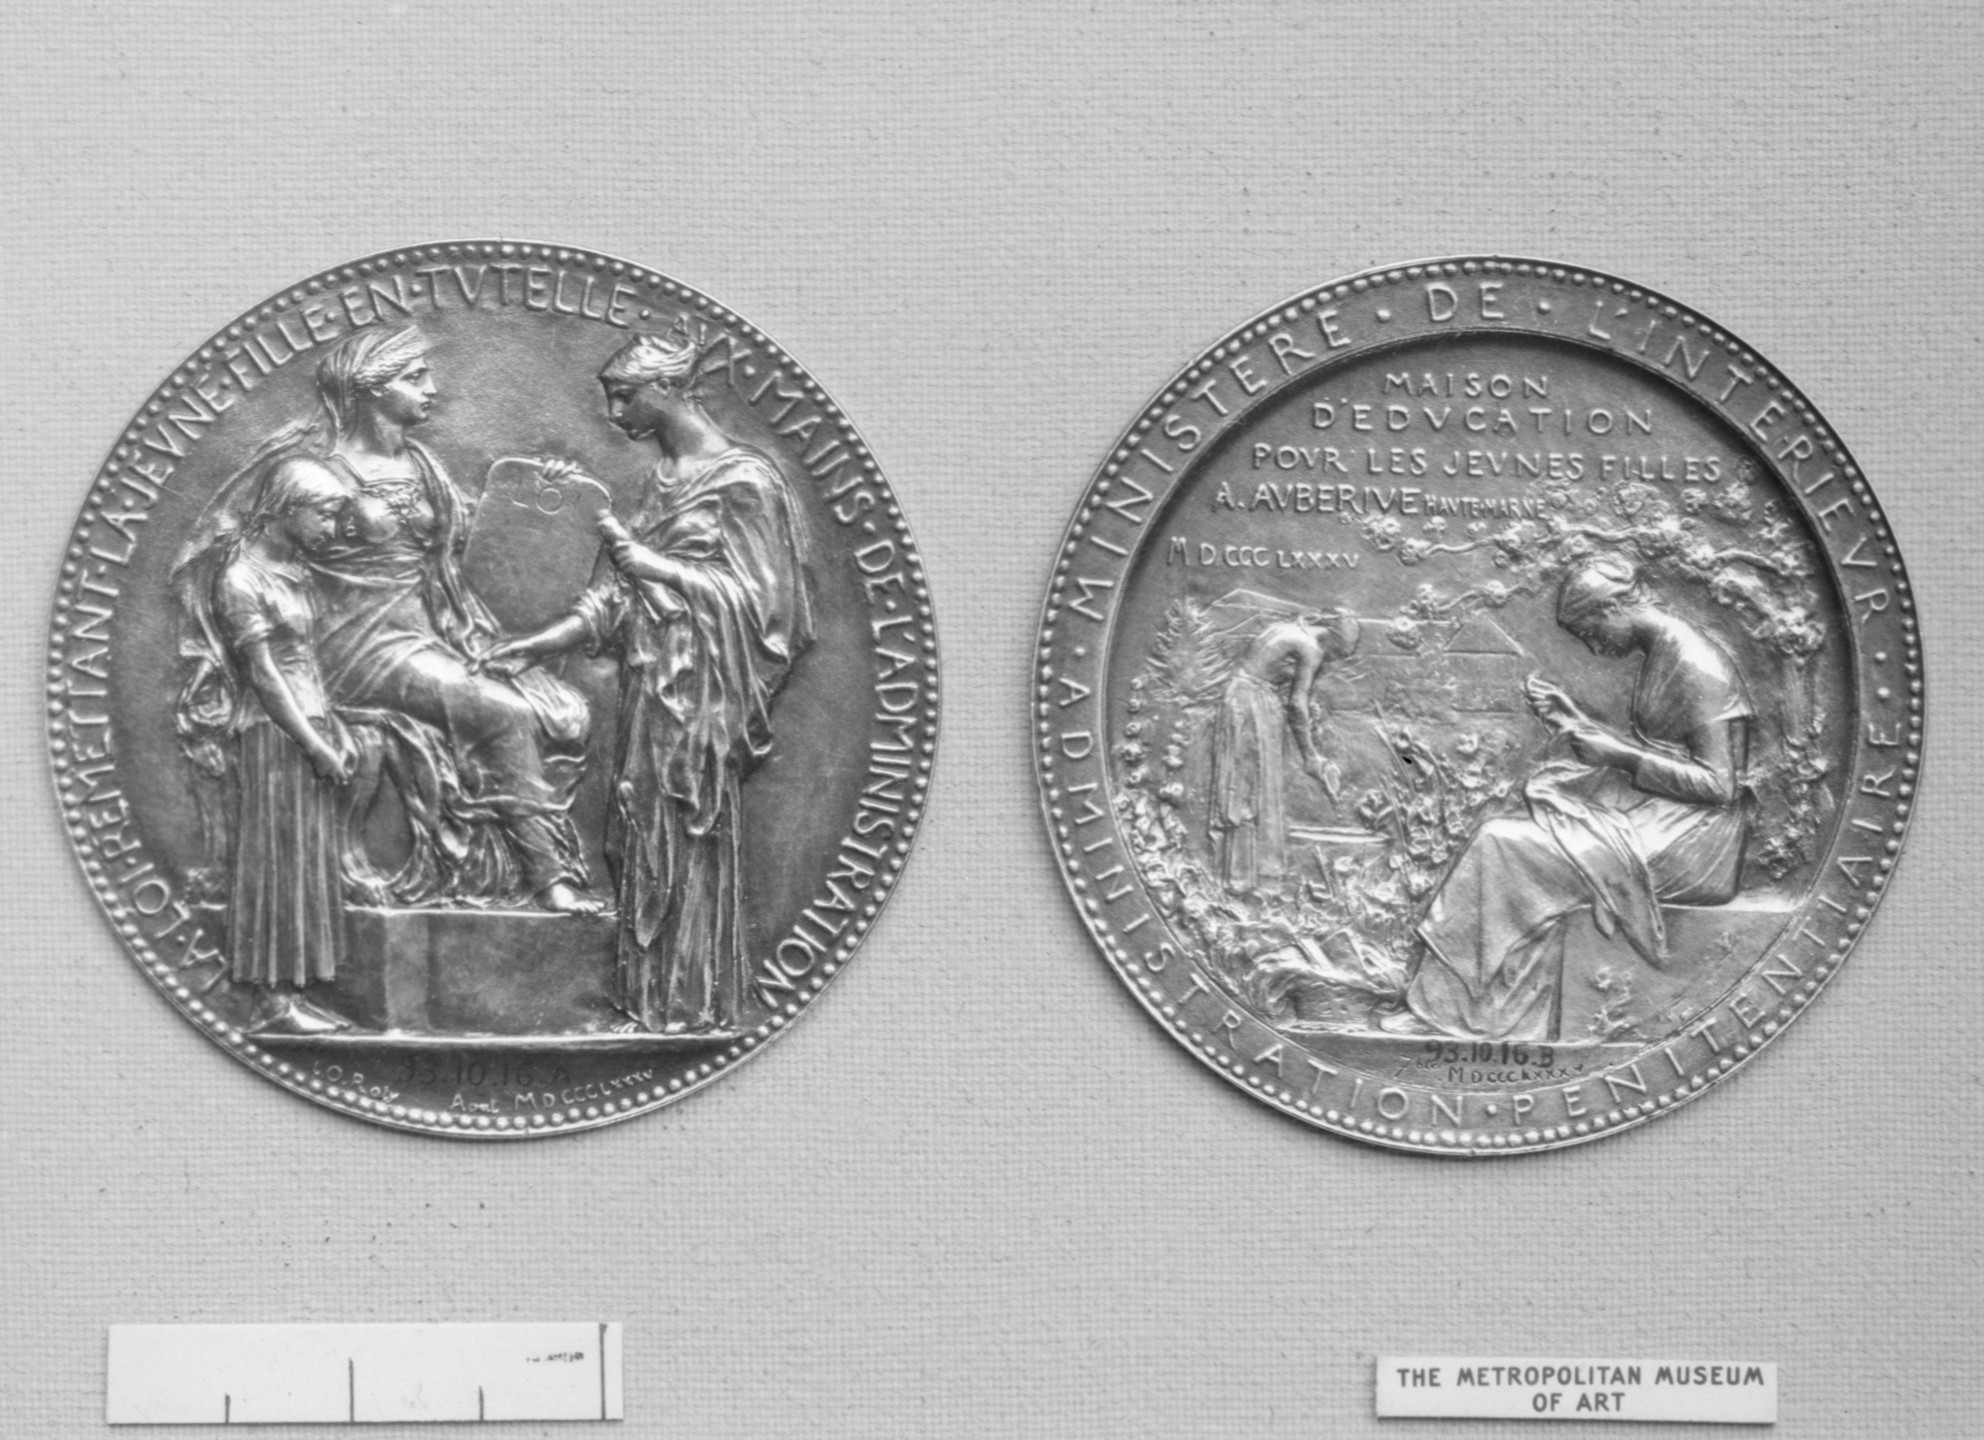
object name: medal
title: The Educational Establishment for Young Women at Auberive, 1885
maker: louis-oscar roty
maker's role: artist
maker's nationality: french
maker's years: 1846-1911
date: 1885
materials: bronze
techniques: silvered, struck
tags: girls,women,sewing